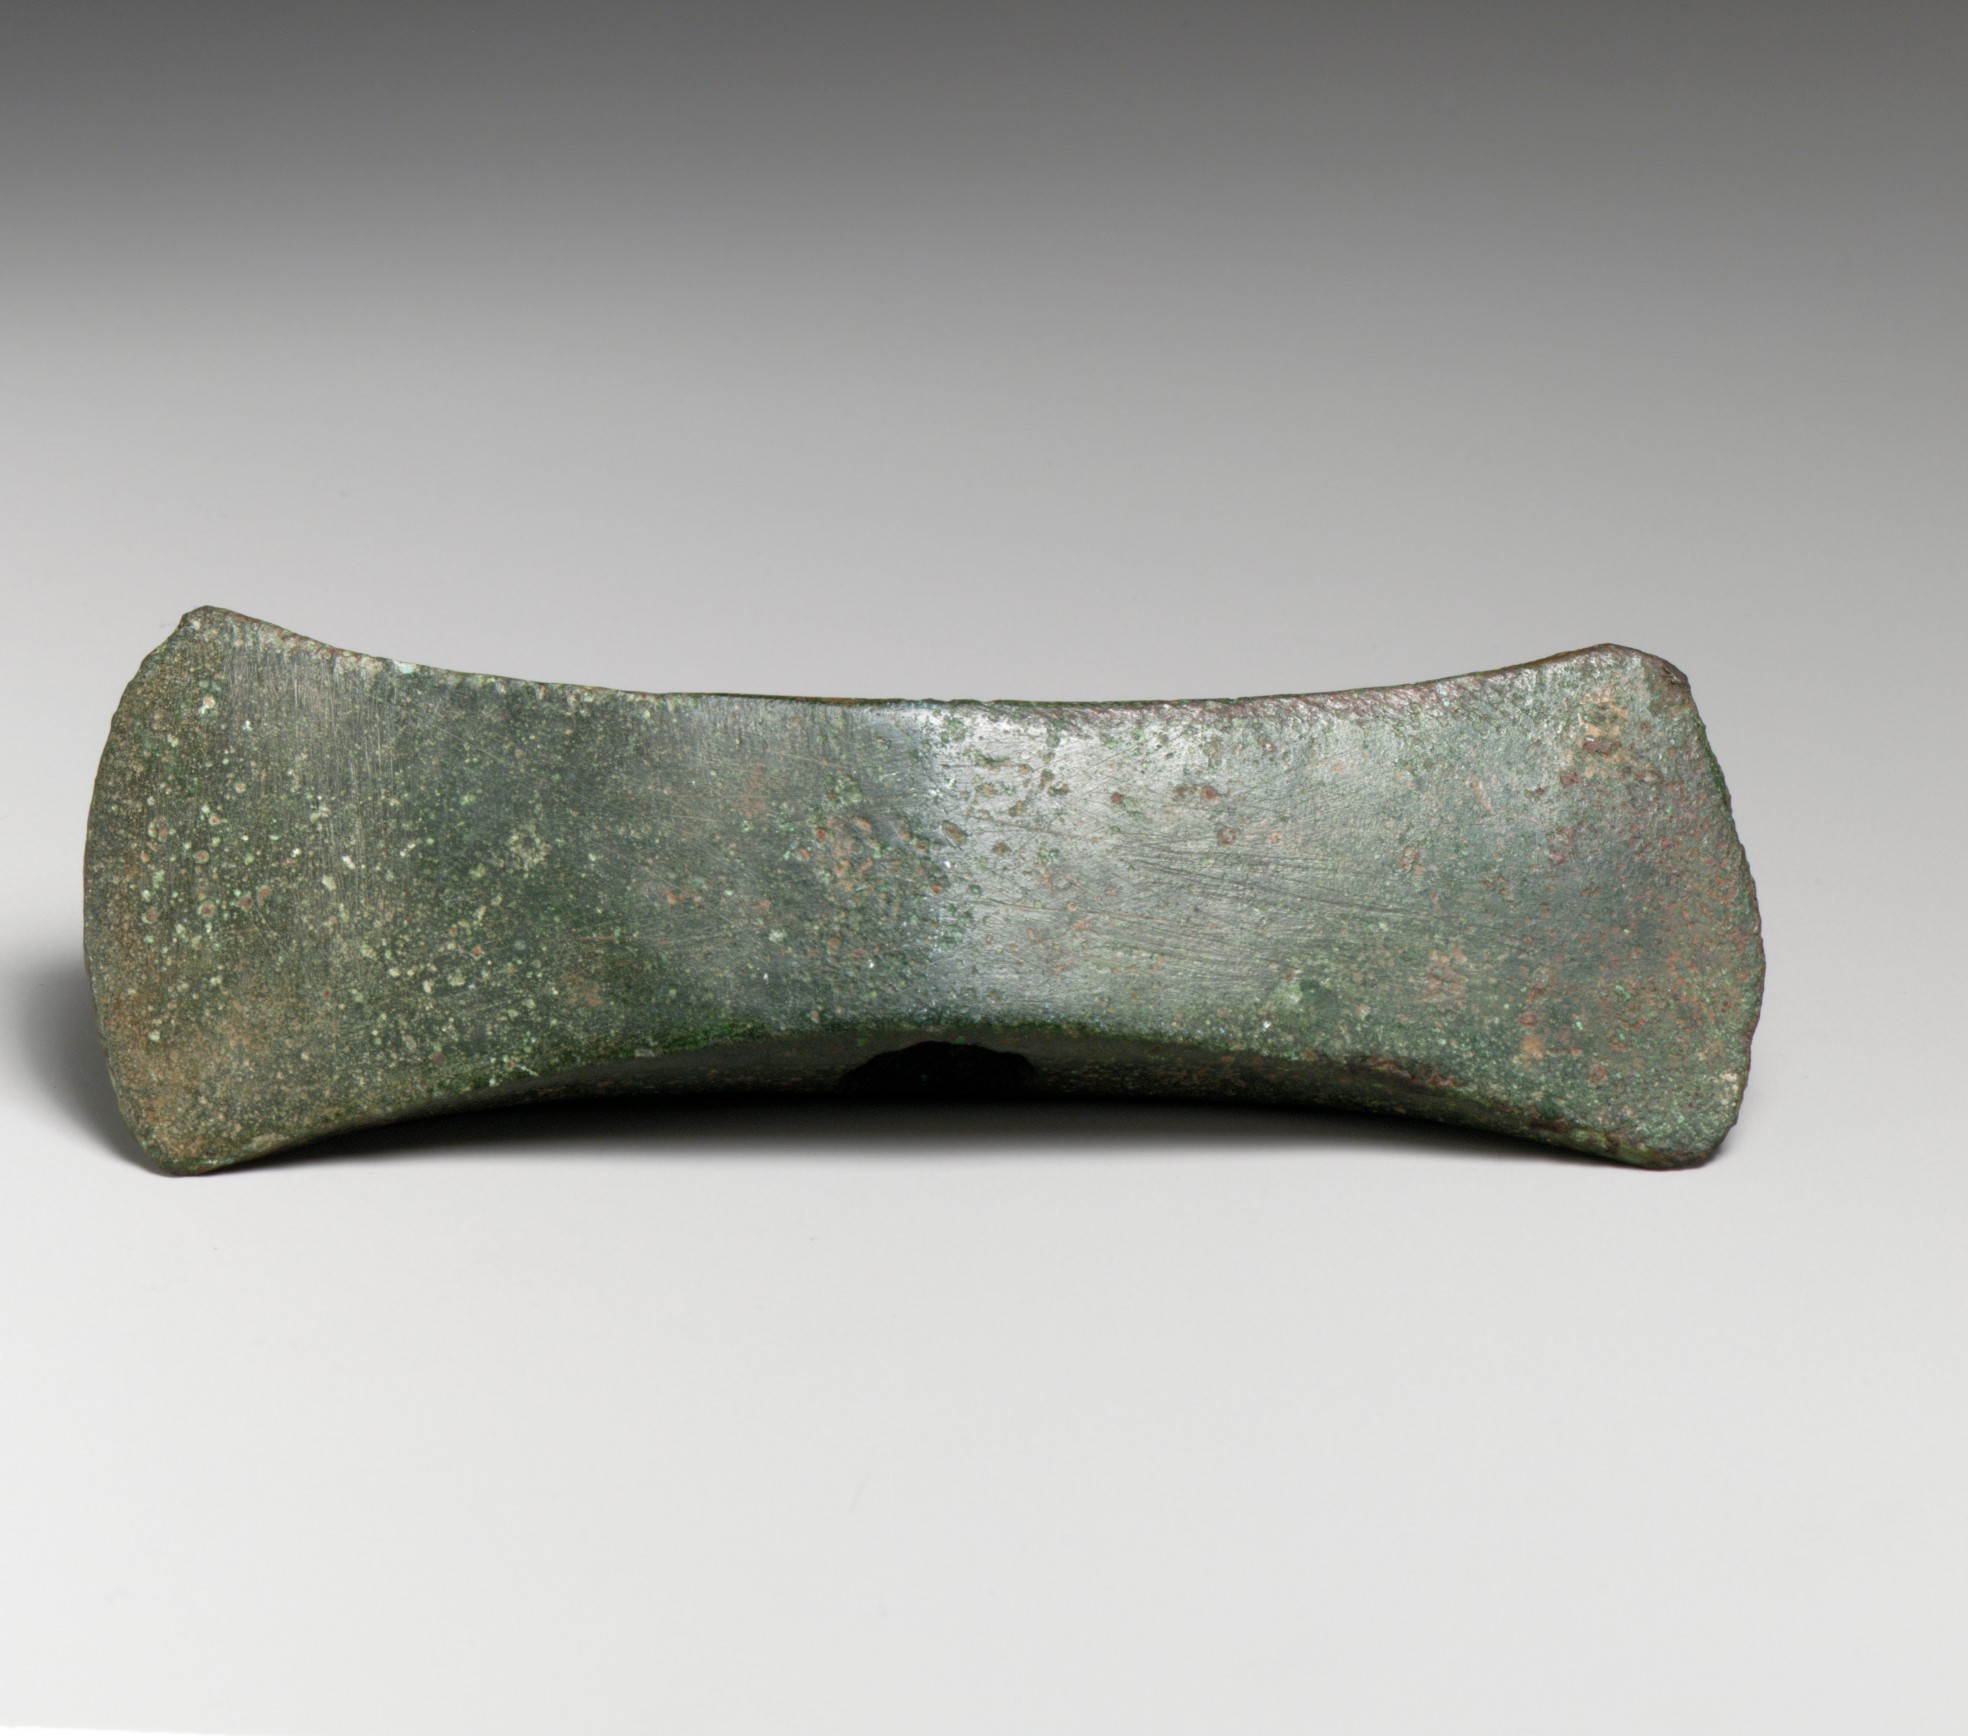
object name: axehead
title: Bronze double axe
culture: minoan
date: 1400-1050 BCE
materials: bronze